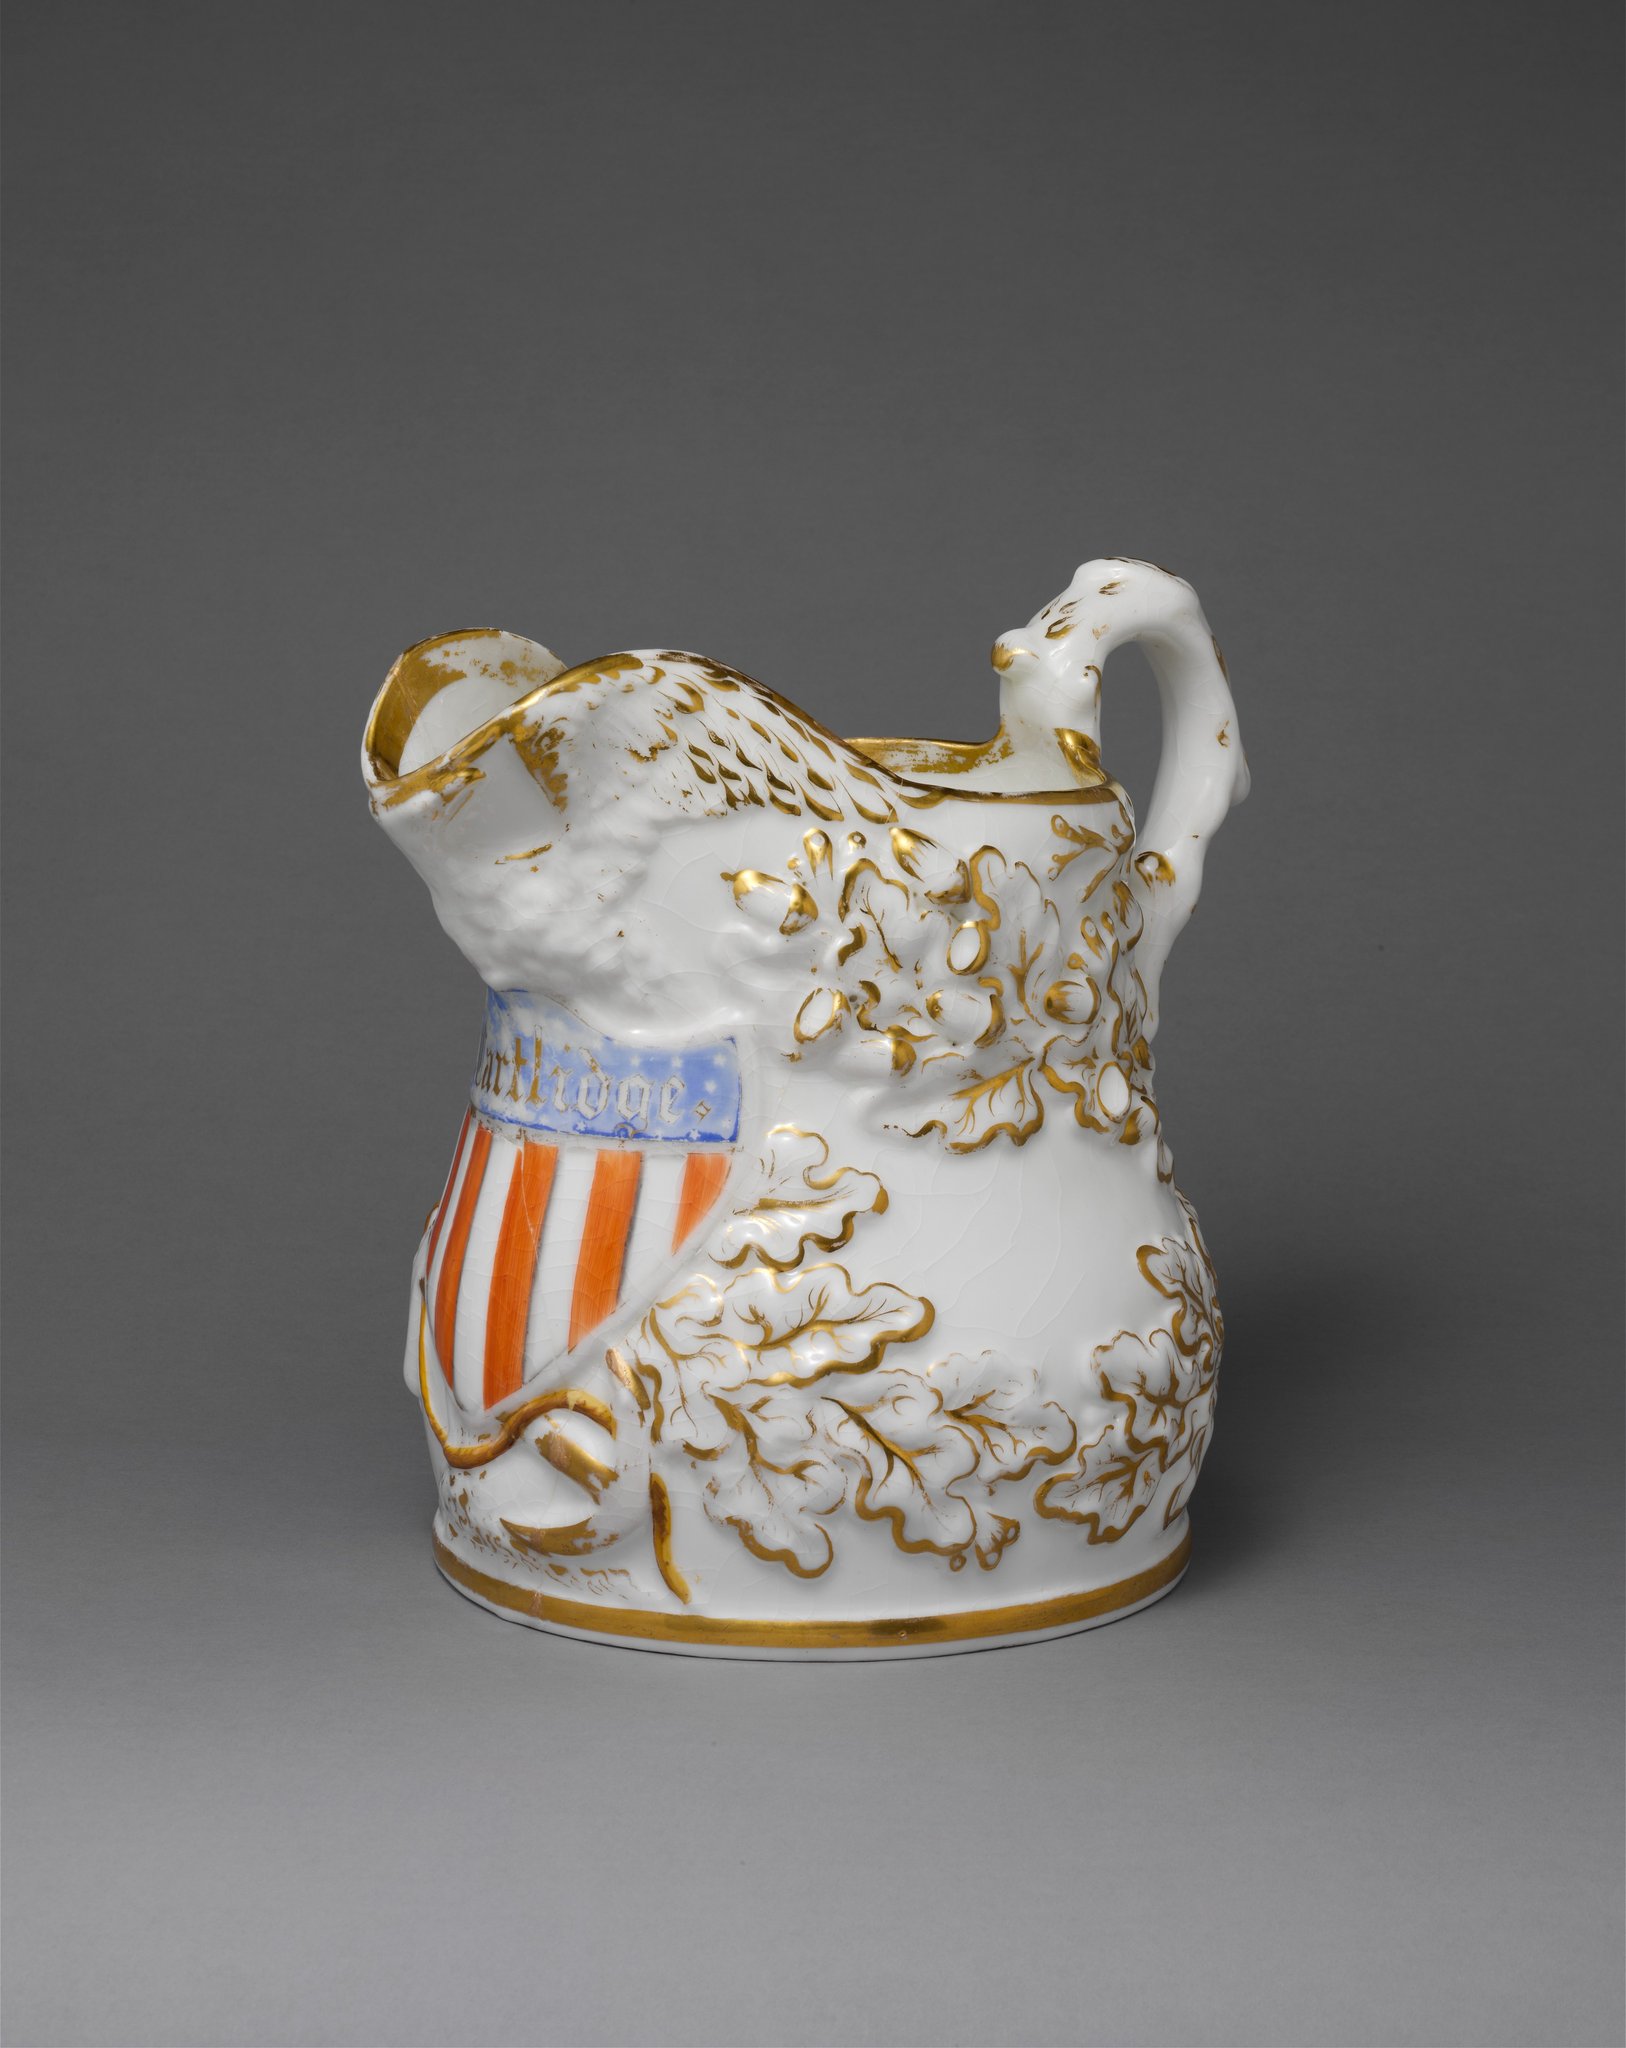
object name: pitcher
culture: american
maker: charles cartlidge and company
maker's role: maker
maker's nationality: american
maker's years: 1848-1856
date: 1848-1856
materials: porcelain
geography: united states